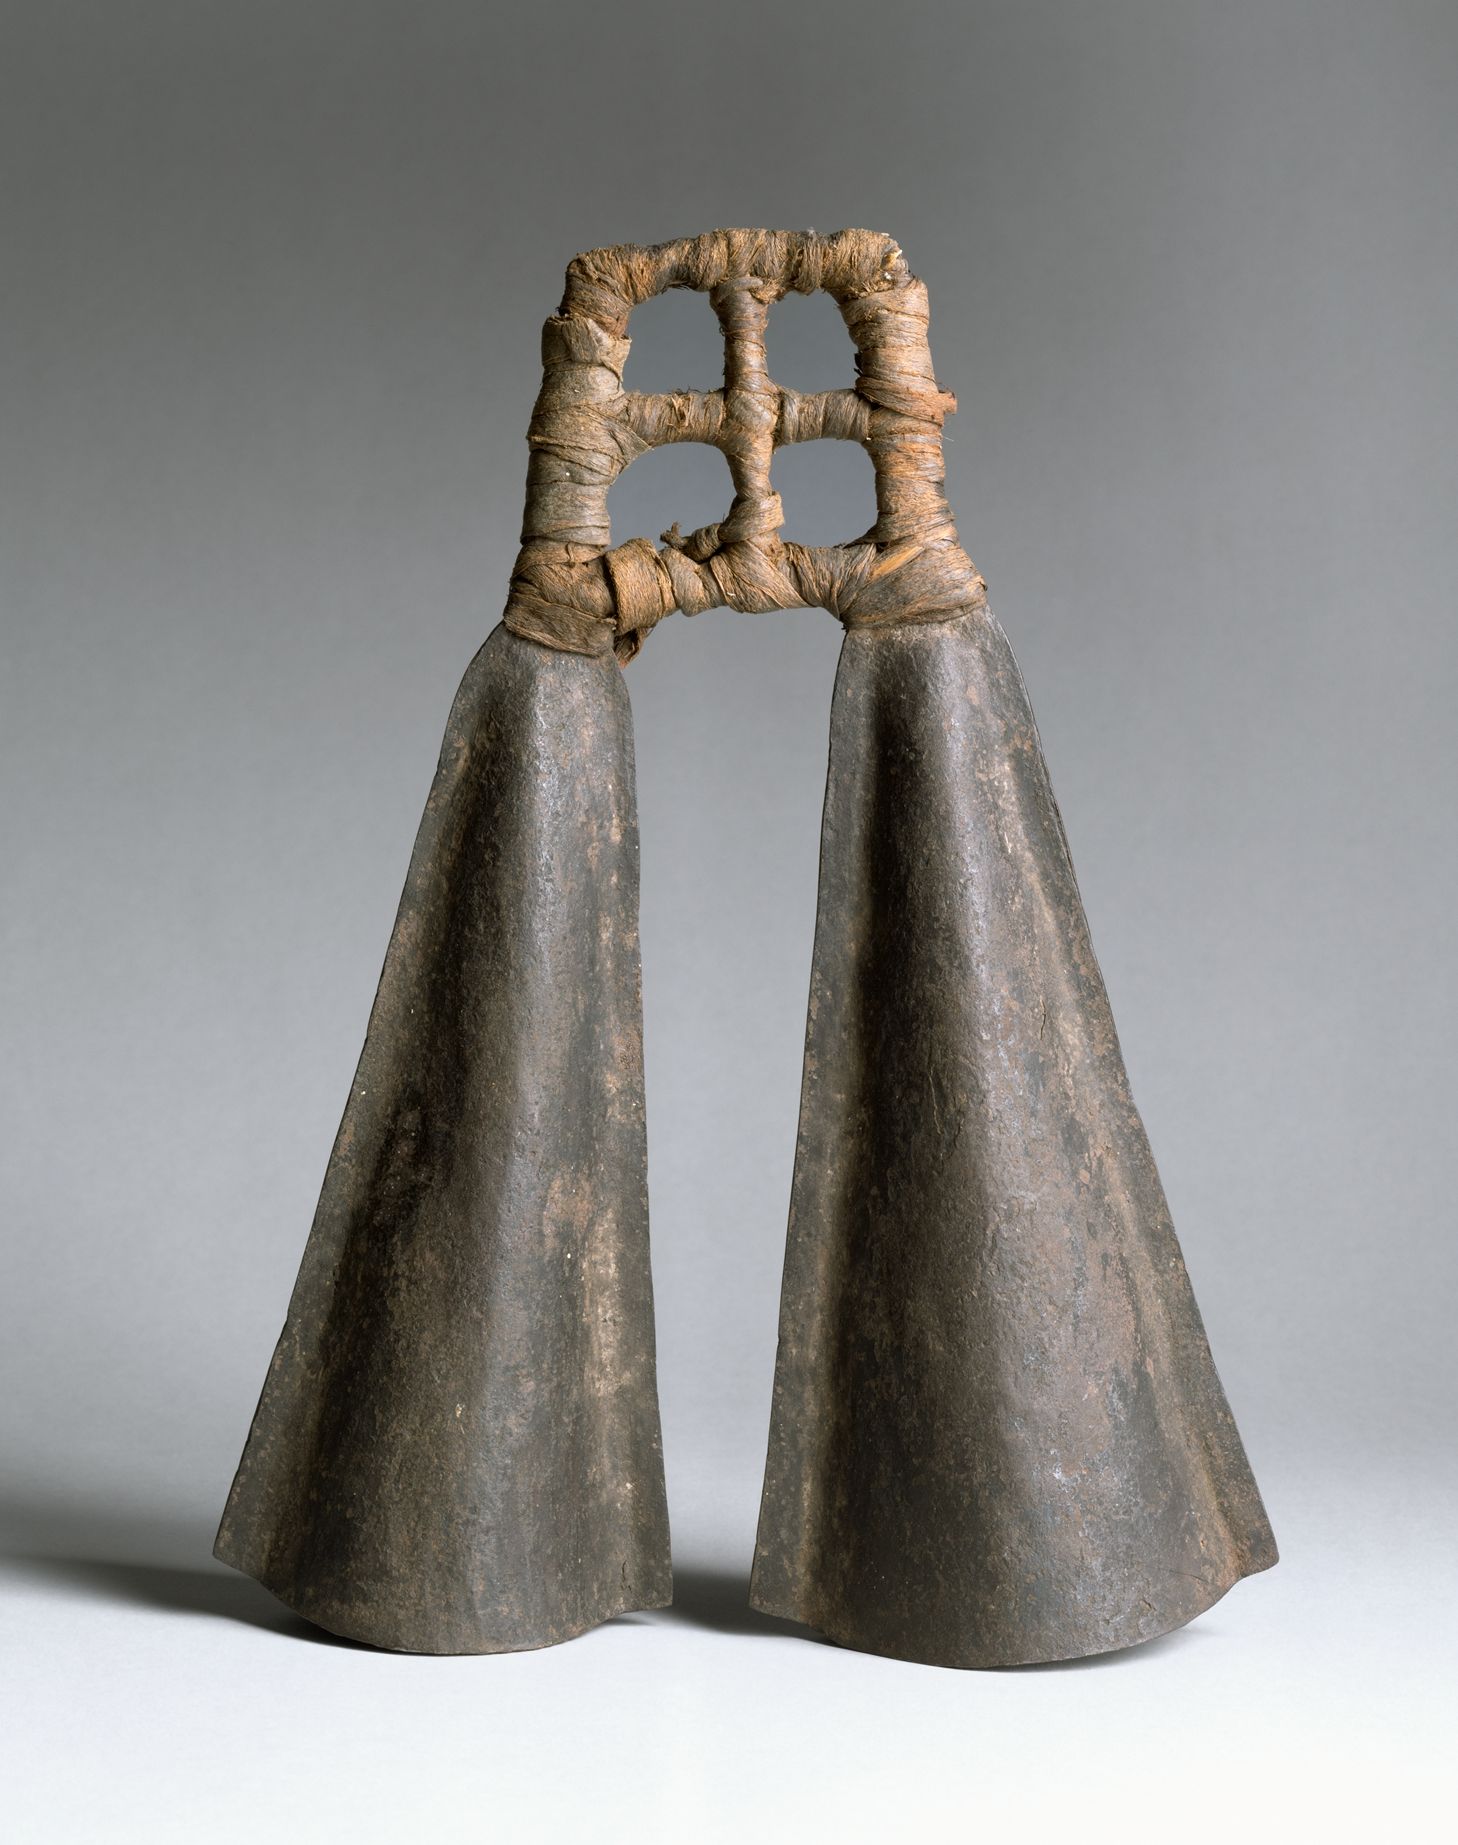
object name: double bell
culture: cameroonian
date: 1867-1900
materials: iron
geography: cameroon